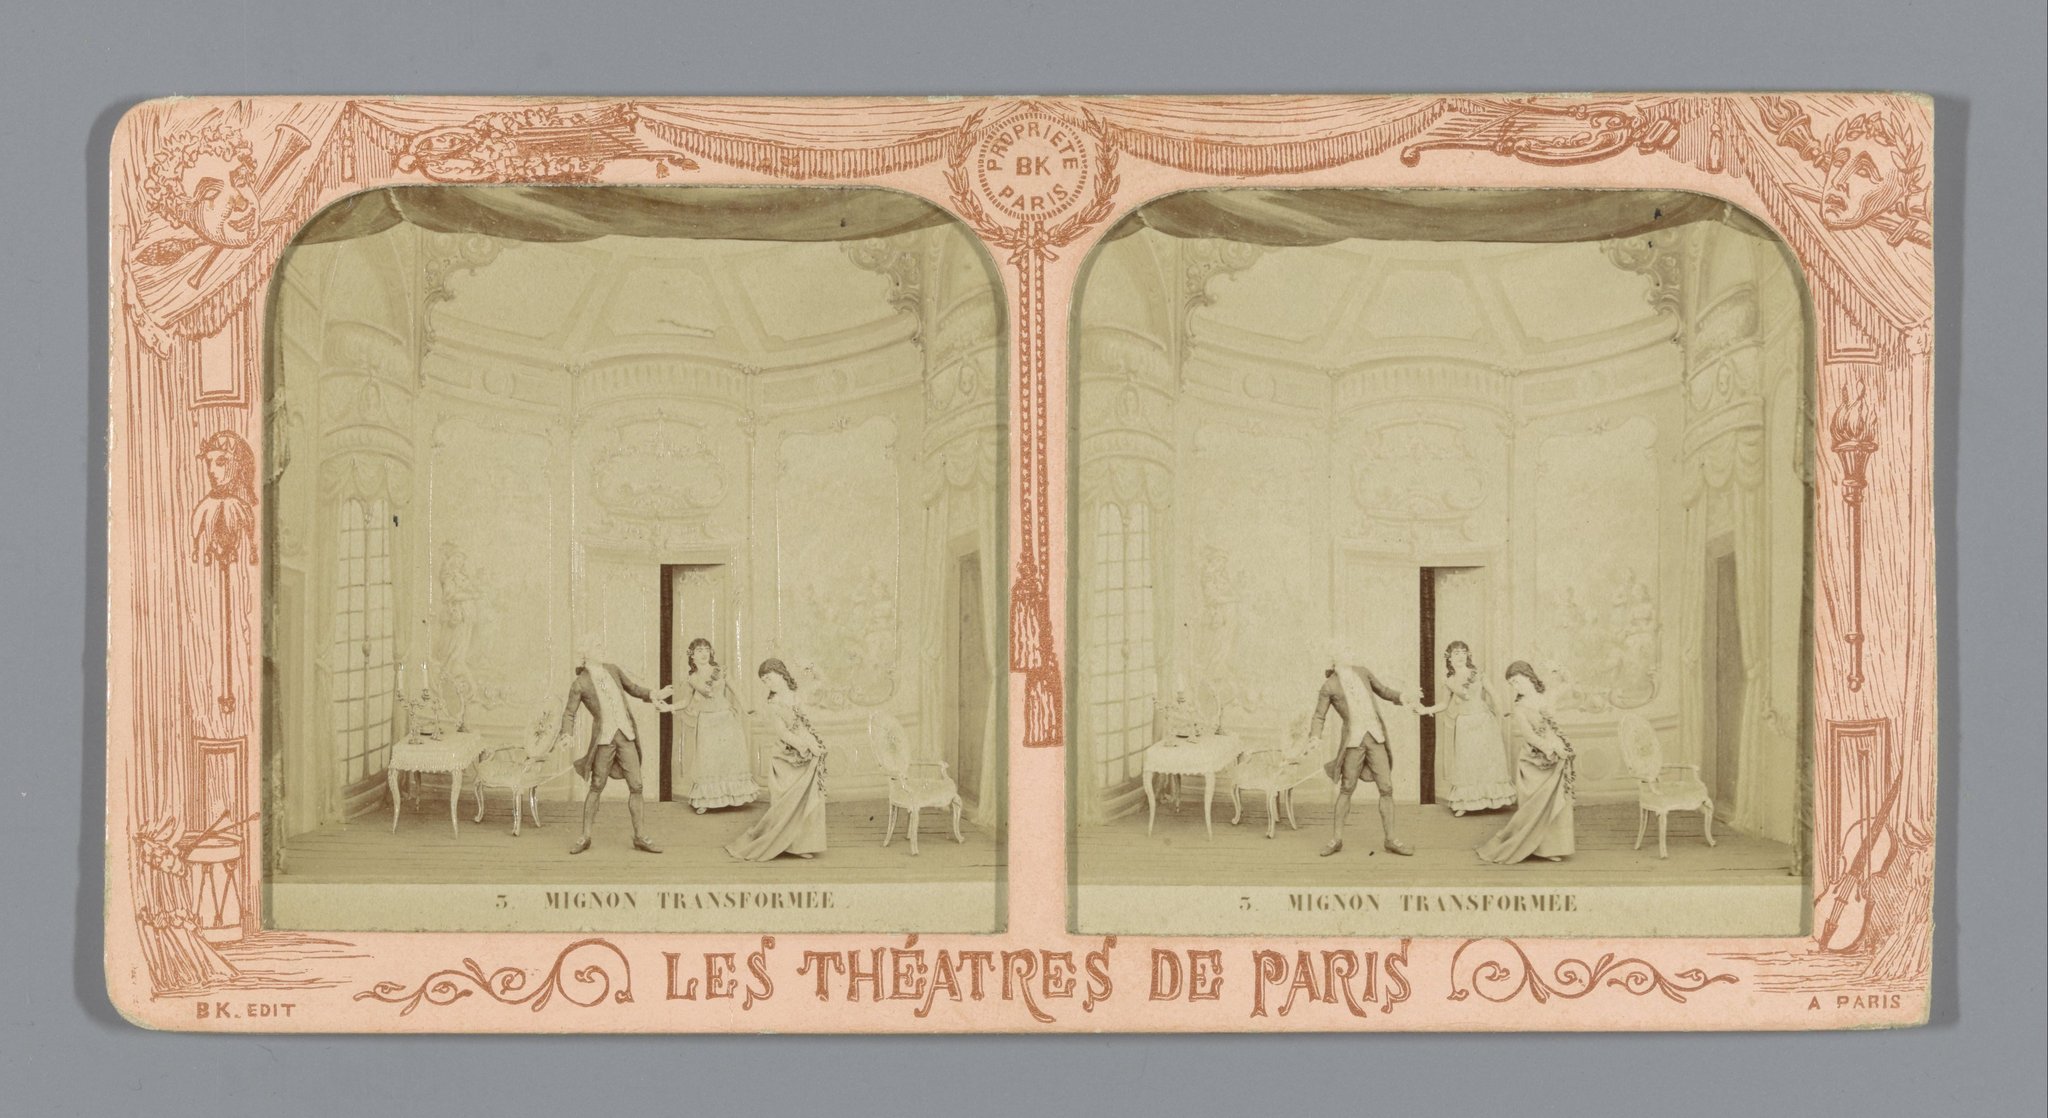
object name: stereograph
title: Stereofoto van het theater in Parijs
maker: Anonymous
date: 1867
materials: cardboard, photographic support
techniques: albumen print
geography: paris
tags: group of actors, troupe; actors on the stage, paris